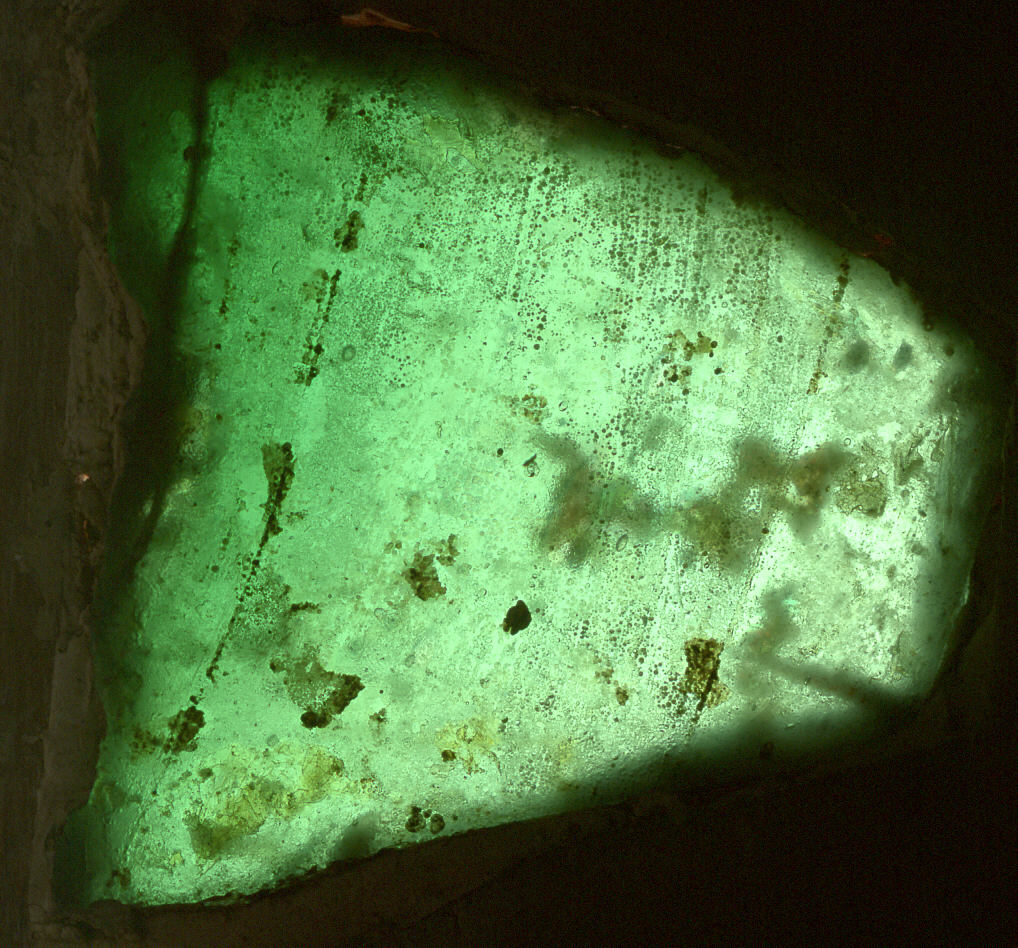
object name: fragment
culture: crusader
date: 1201-1300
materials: glass